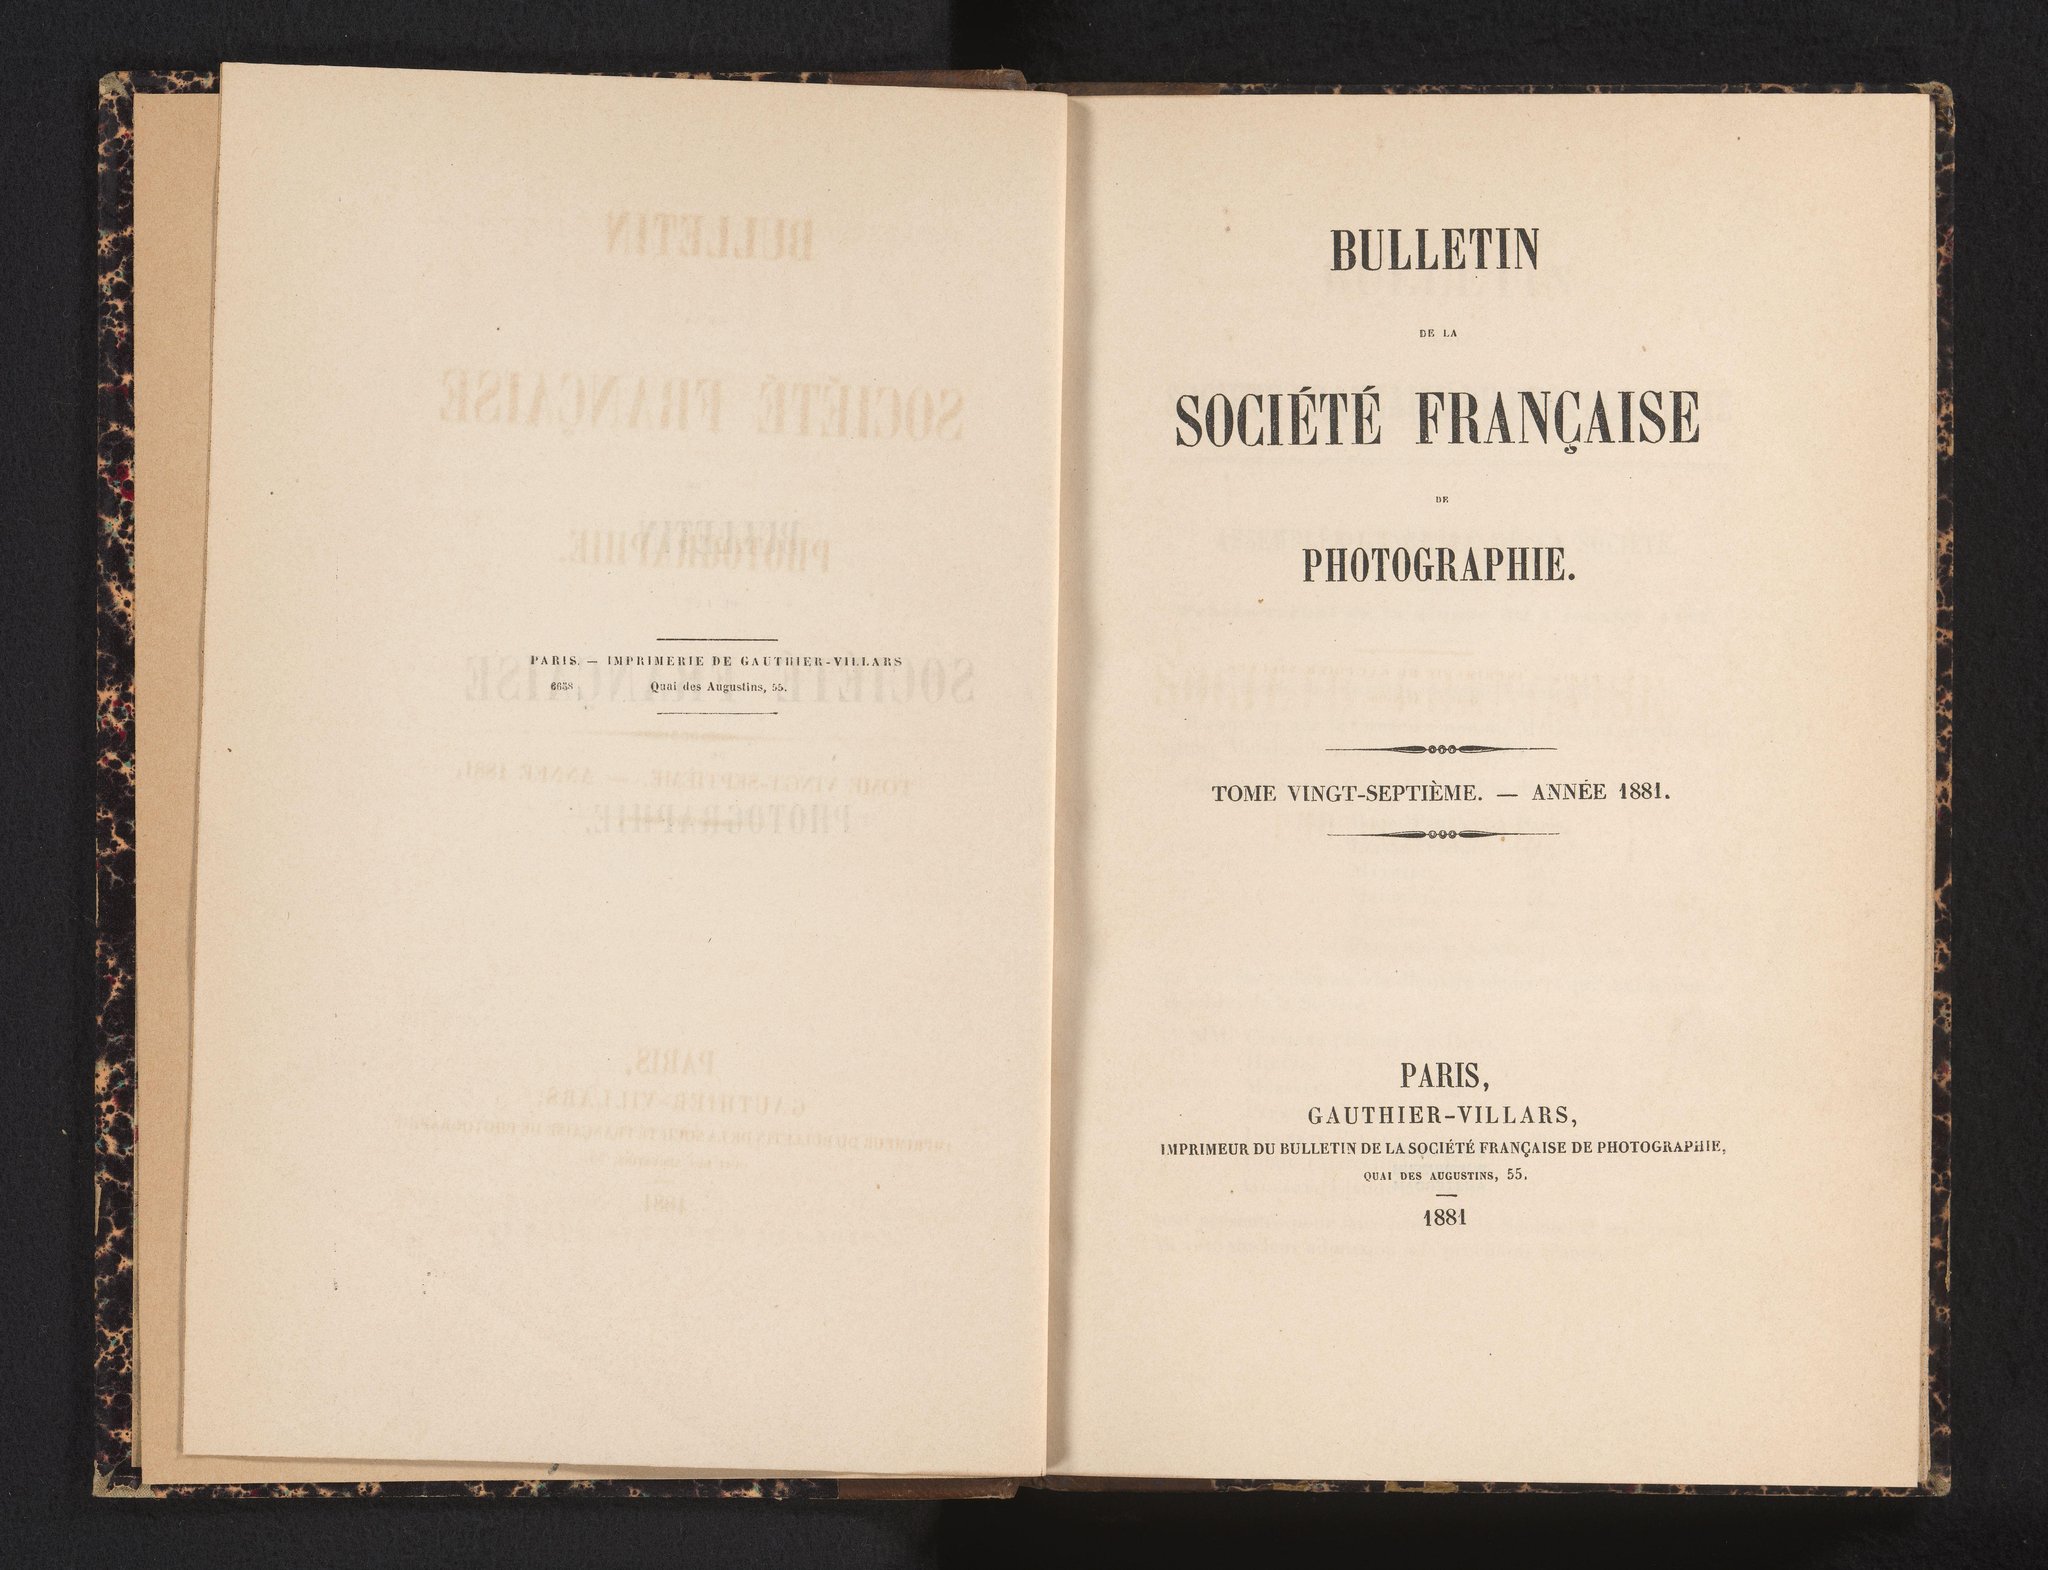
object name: book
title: Bulletin de la Société française de photographie. Tome vingt-septième - année 1881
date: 1881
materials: paper, cardboard, leather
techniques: letterpress printing, marbling, photoaquatint, marbled paper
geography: paris